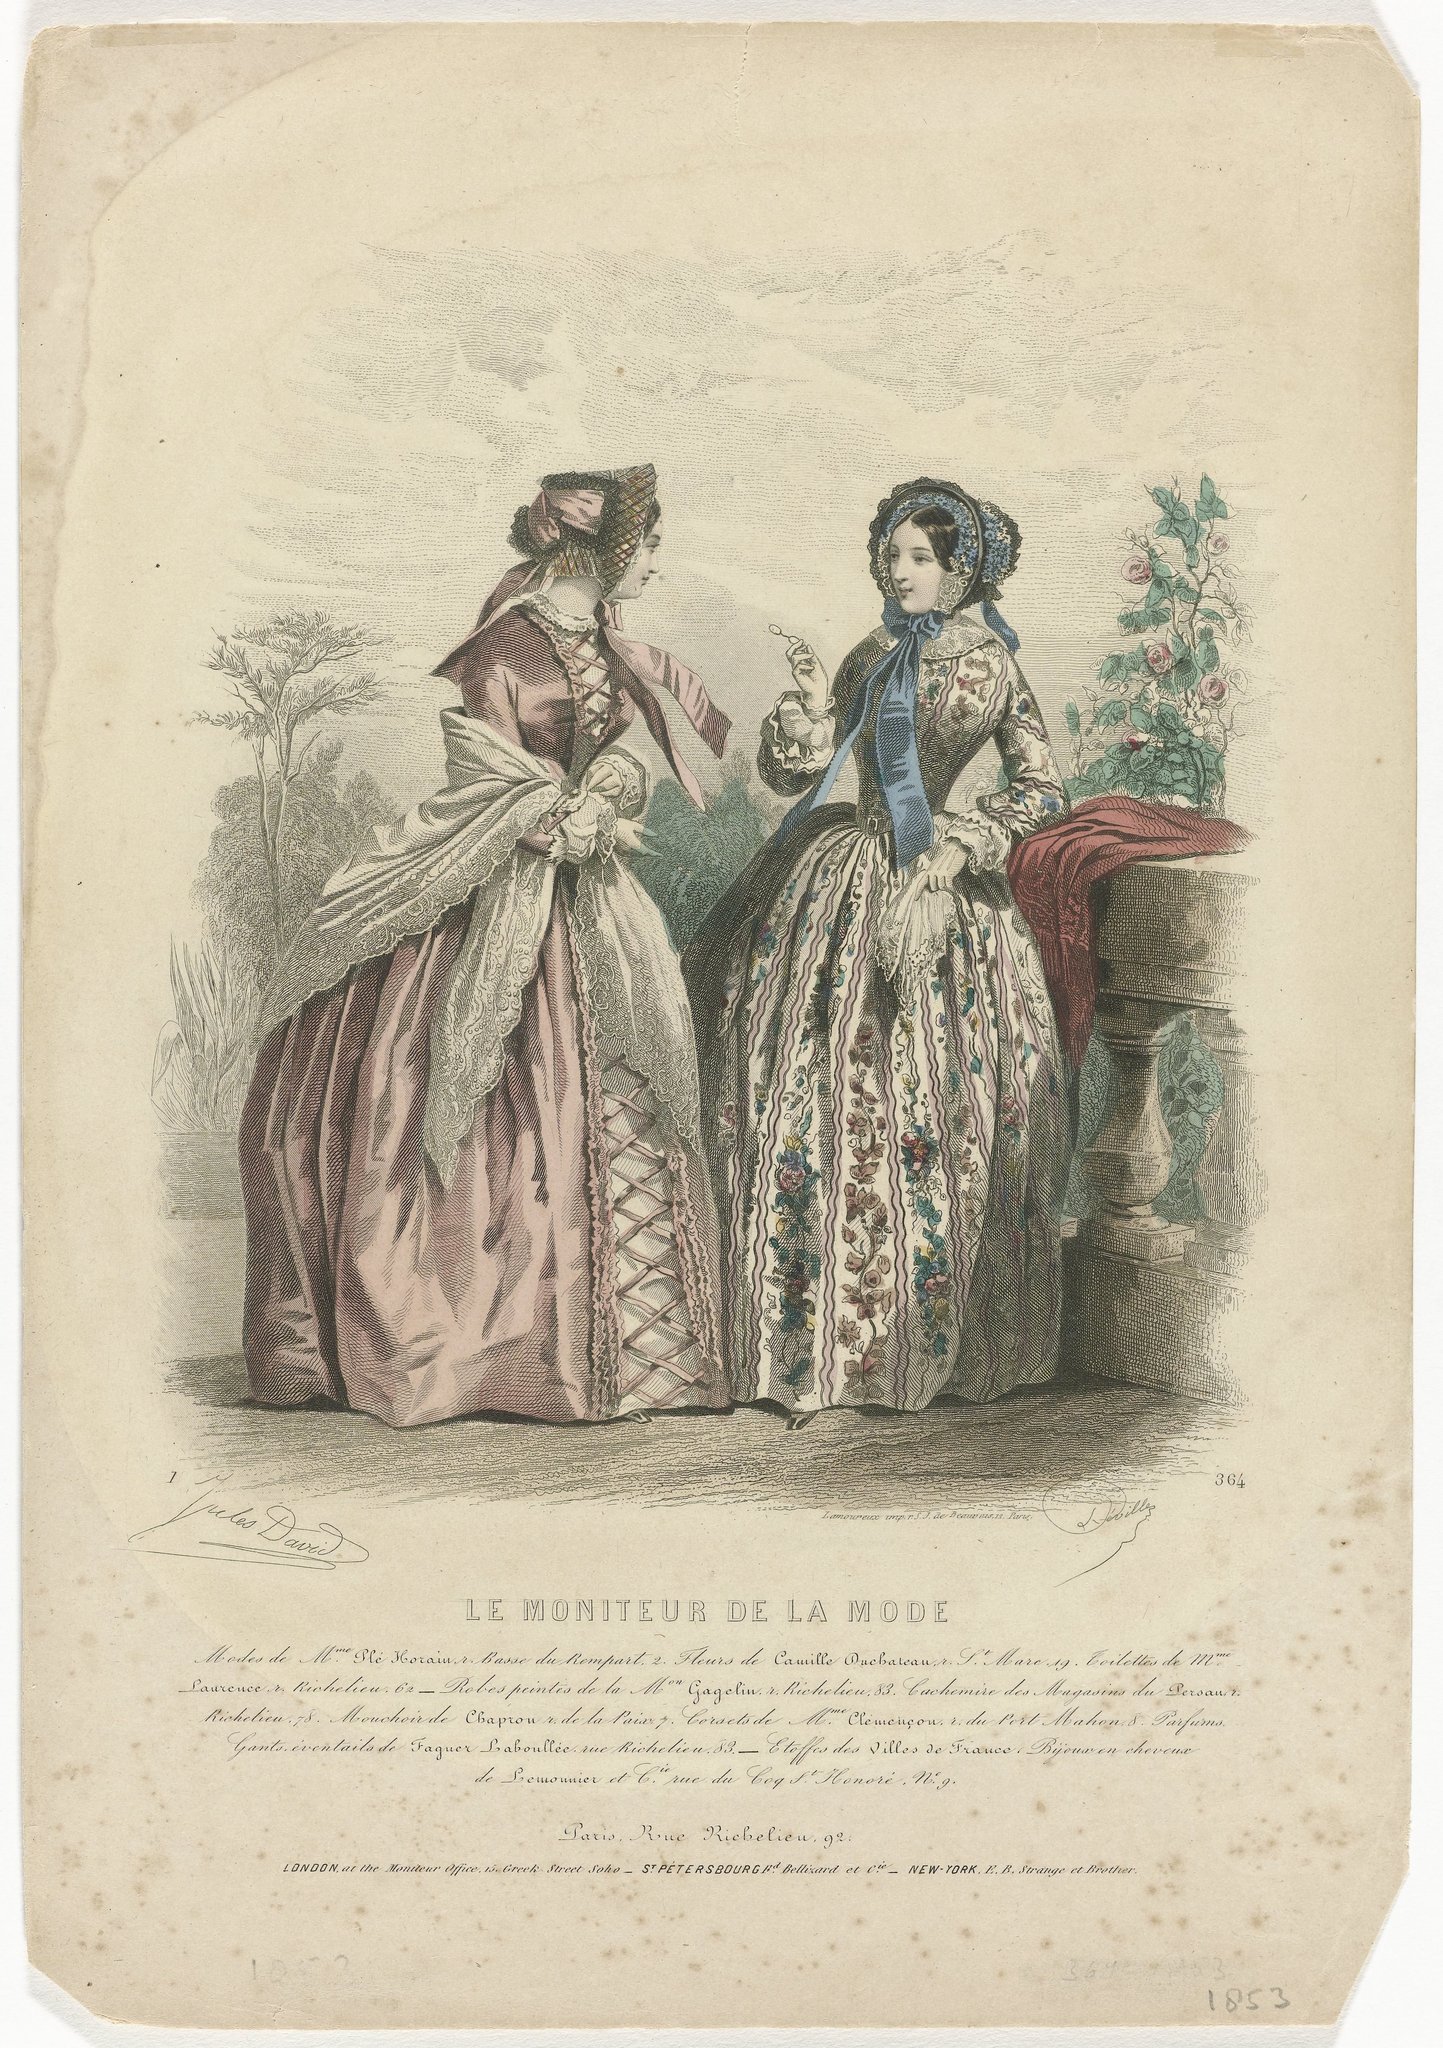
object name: fashion print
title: Le Moniteur de la mode, 1853, No. 364 : Modes de Mme Plé Horain (...)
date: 1853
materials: paper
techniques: hand coloring, engraving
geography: new york city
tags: handkerchief (+ women's clothes), clothing for the upper part of the body (shawl) (+ women's clothes), fashion plates, head-gear: hat (+ women's clothes), gloves, mittens, etc. (+ women's clothes), fan (+ women's clothes)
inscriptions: title: ‘Le Moniteur de la Mode.’, address: ‘Paris, rue Richelieu, 92. / London at the Moniteur Office, 15, Greek Street Soho _ S.t Pétersbourg F.d Bellizard et C.ie _ New-York. E.B. Strange et Brother.’, caption: ‘Modes de M.me Plé Horain, r. Basse du Rempart, 2. Fleurs de Camille Duchateau, r. S.t Marc, 19. Toilettes de M.me Laurence. r. Richelieu. 62 _ Robes peintes de la Mon Gagelin, r. Richelieu, 83. Cachemire des Magasins du Persau. r. Richeliue. 78. Mouchoir de Chapron r. de la Paix 7. Corsets de M.me Clemençon. r. du Port Mahon, 8. Parfums. Gants, éventails de Faguer Laboullée. rue Richelieu, 83. _ Etoffes des Villes de france. Bijoux en cheveux de Lemonnier et C.ie rue du Coq S.t Honoré. No.9.’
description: Twee vrouwen bij een balustrade. Volgens het onderschrift: 'modes' van Plé Horain. 'Toilettes' van Laurence. Japonnen van geschilderde stof van Maison Gagelin. Kasjmier van 'Magasins du Persau'. Hieronder enkele regels reclametekst voor verschillende producten. Prent uit het modetijdschrift Le Moniteur de la mode (1843-1913).